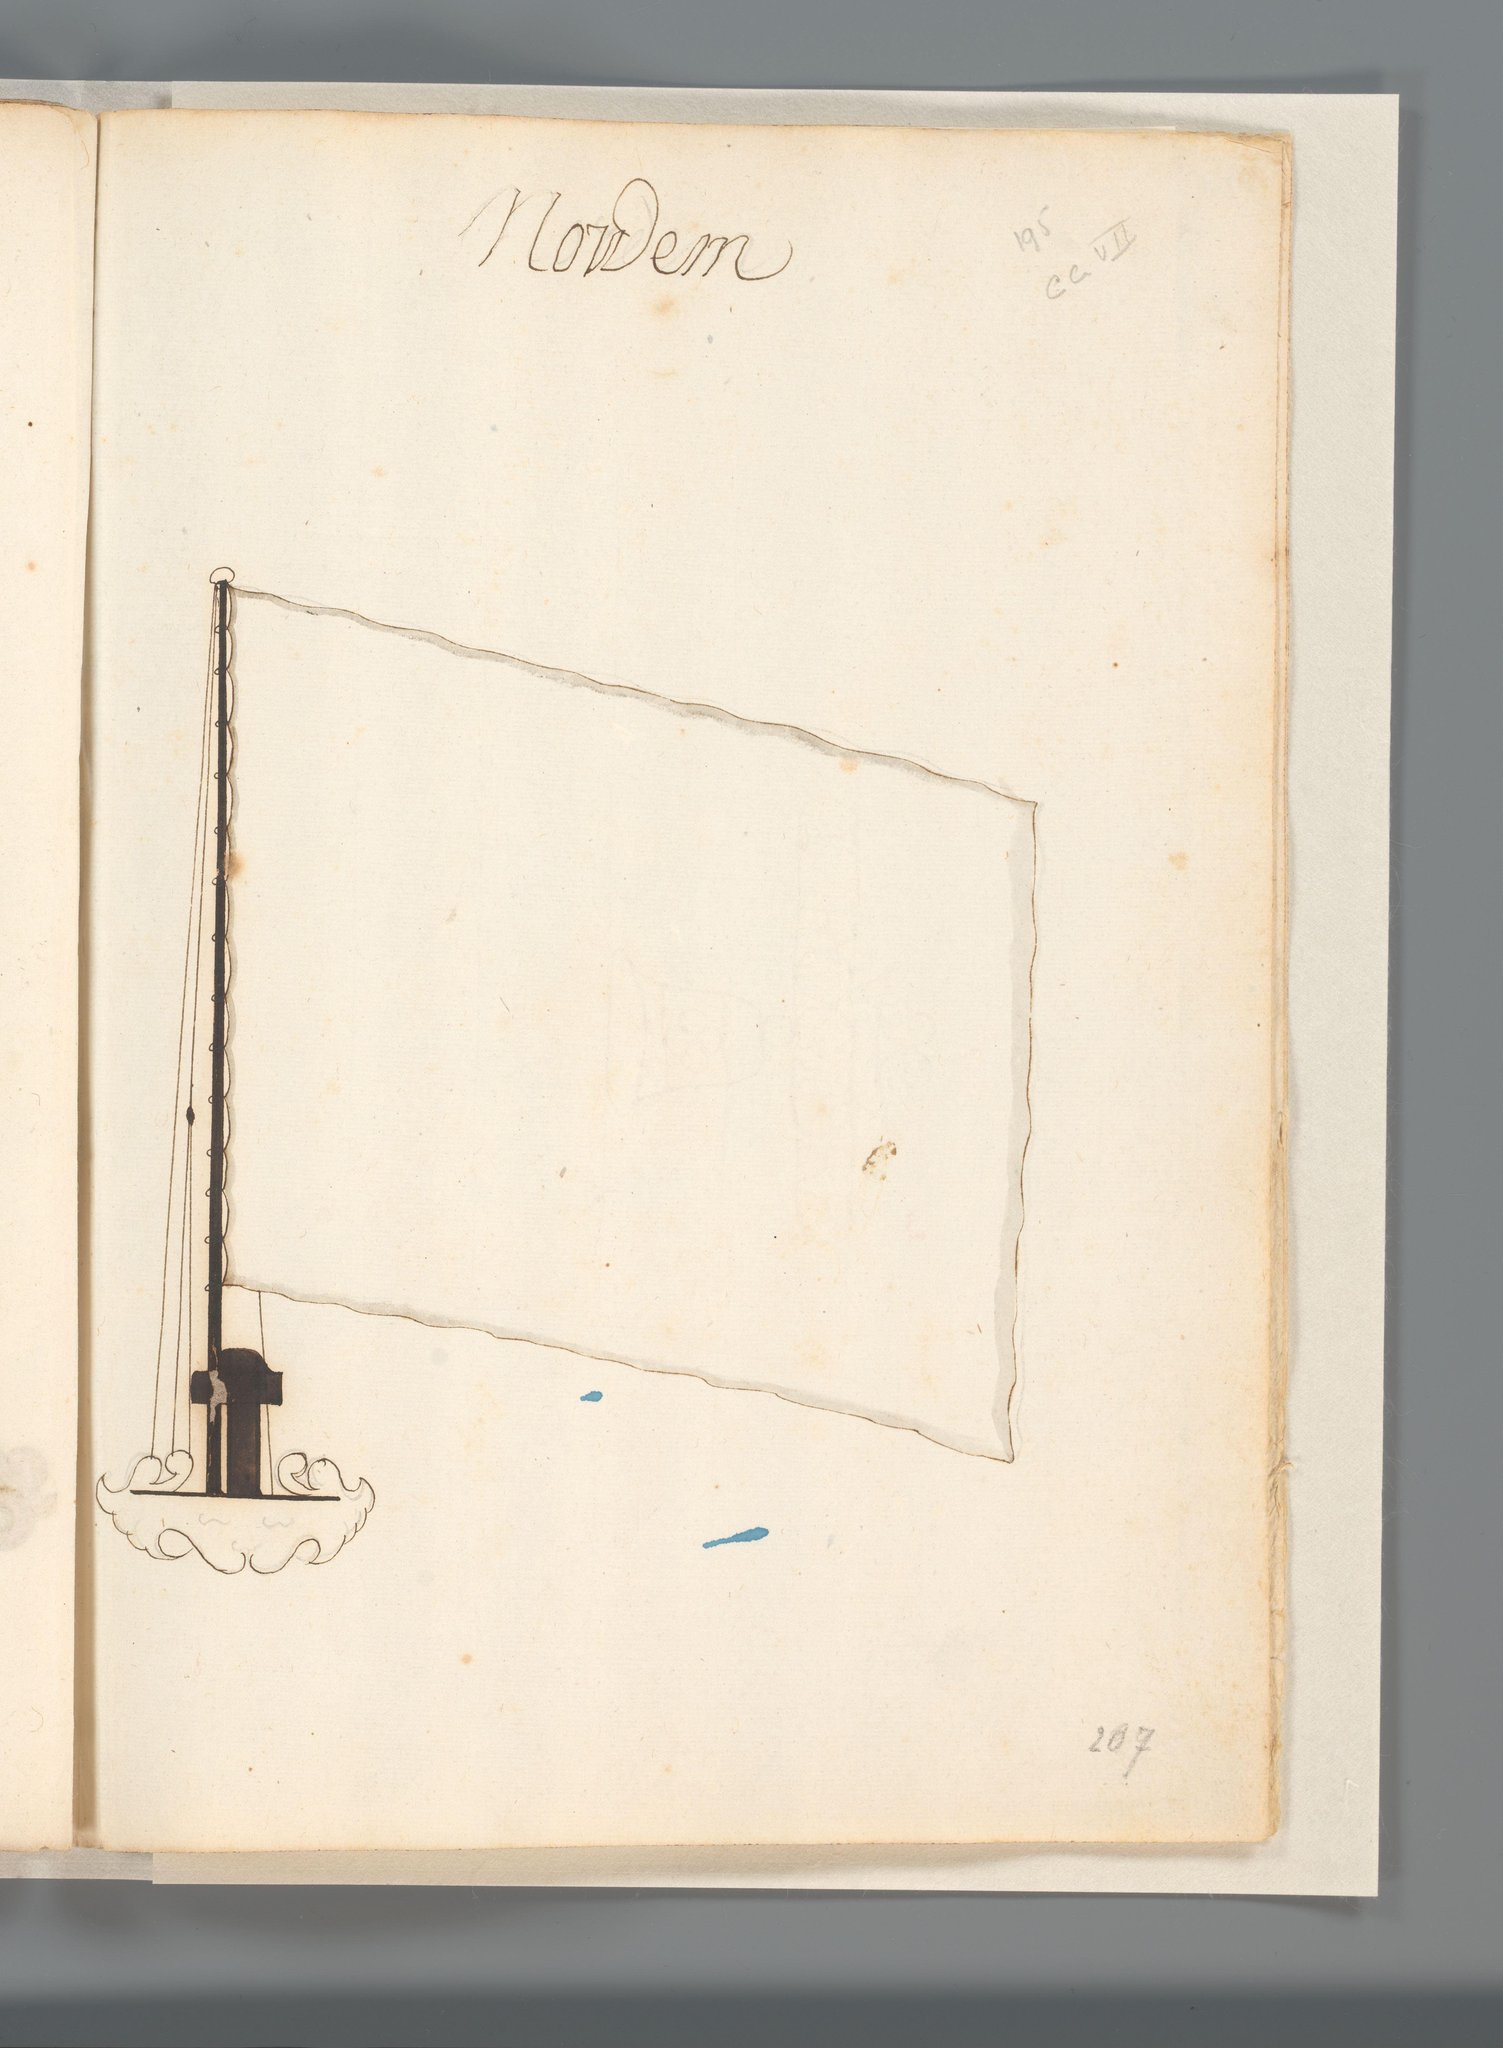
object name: drawing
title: Vlag van Norden (blanco)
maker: Anonymous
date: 1667-1670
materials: ink, paper, watercolor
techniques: brush, pen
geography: france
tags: flag, colours (as symbol of the state, etc.)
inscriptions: number: ‘195 / CCVII / 207’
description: Blanco, oningevulde vlag, bestemd voor de vlag van de stad Norden. Vlag op vlaggensteng en mastvoet. Afgebeeld op folio 104r. Onderdeel van een vlaggenboek met vlaggen uit Europa, Noord-Afrika, Nabije en Verre Oosten.